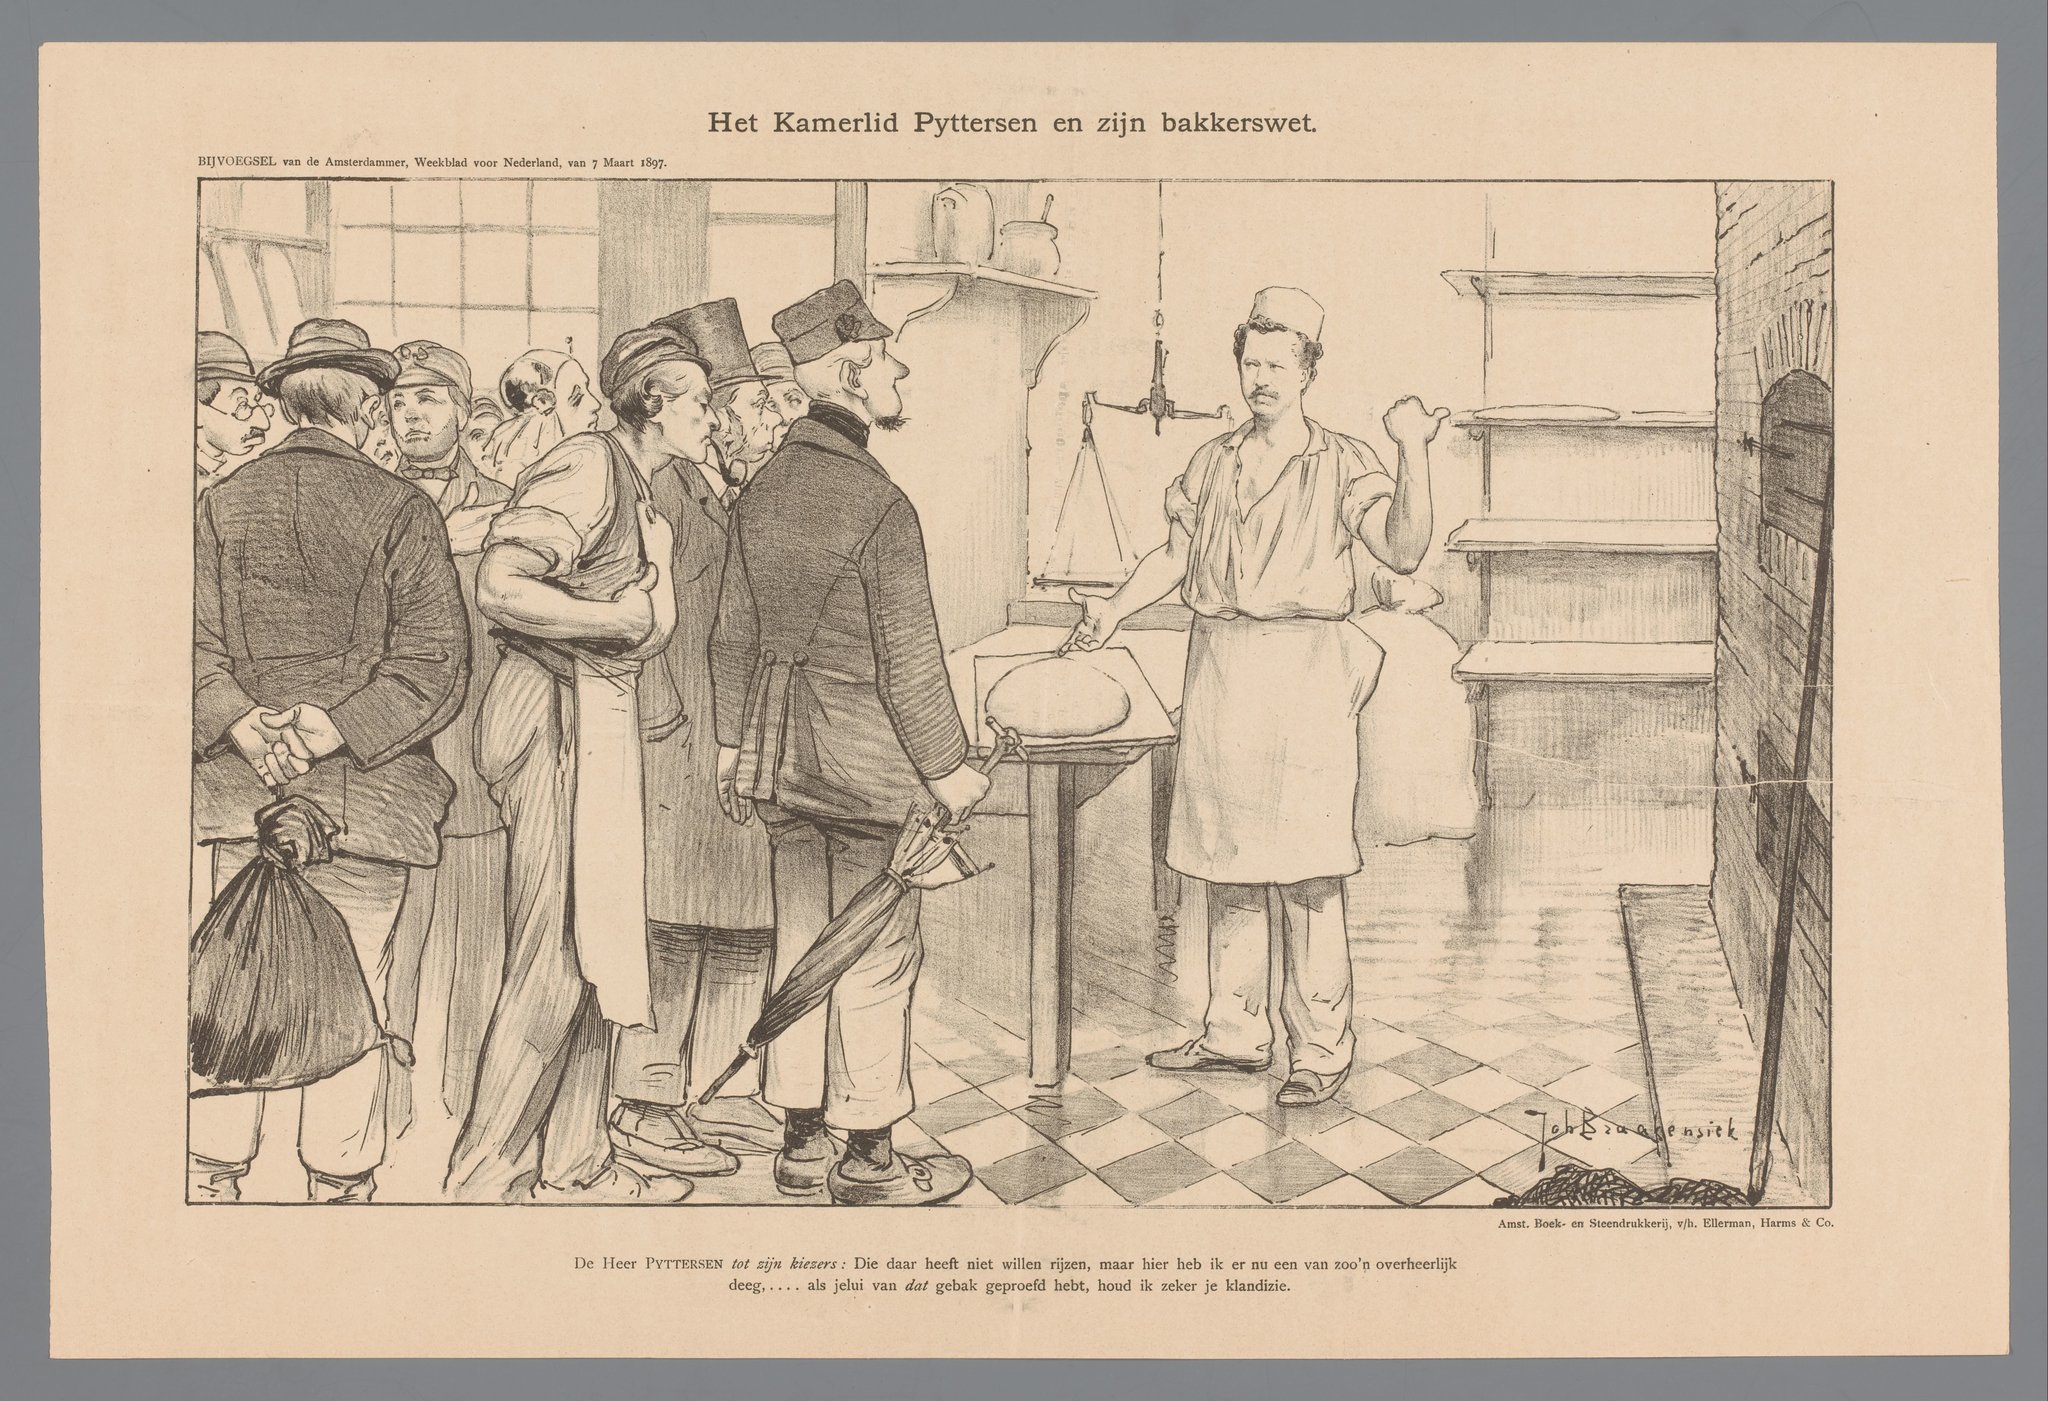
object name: cartoon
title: Het kamerlid Pyttersen en zijn bakkerswet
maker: johan braakensiek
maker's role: draughtsman, print maker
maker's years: 1858-1940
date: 1897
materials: paper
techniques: lithograph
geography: amsterdam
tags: politician, baker, political caricatures and satires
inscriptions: date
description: Prent uit het bijvoegsel van: De Amsterdammer. Weekblad voor Nederland, 7 maart 1897.